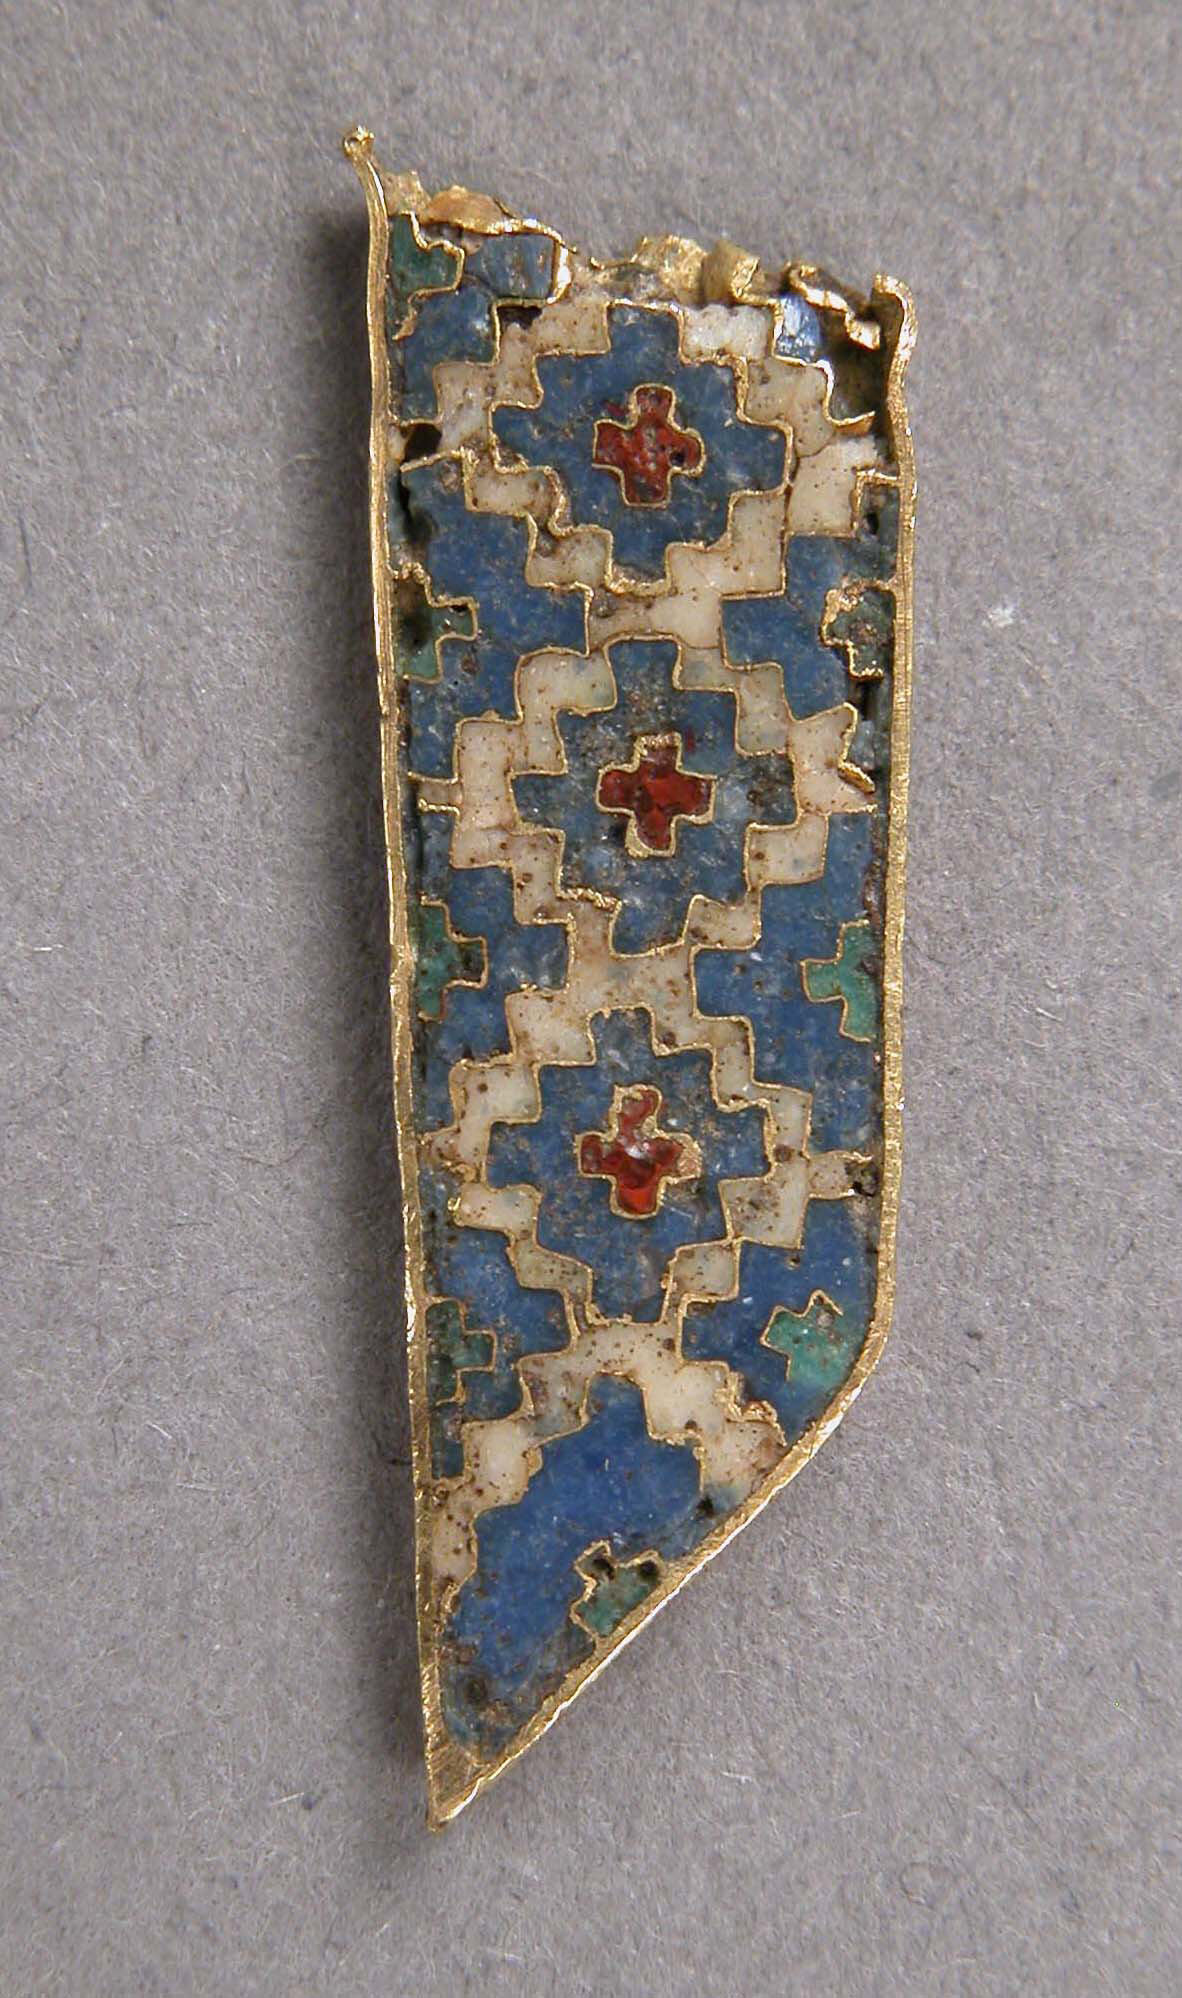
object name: border fragment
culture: byzantine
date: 901-1000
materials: enamel, gold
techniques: enamel